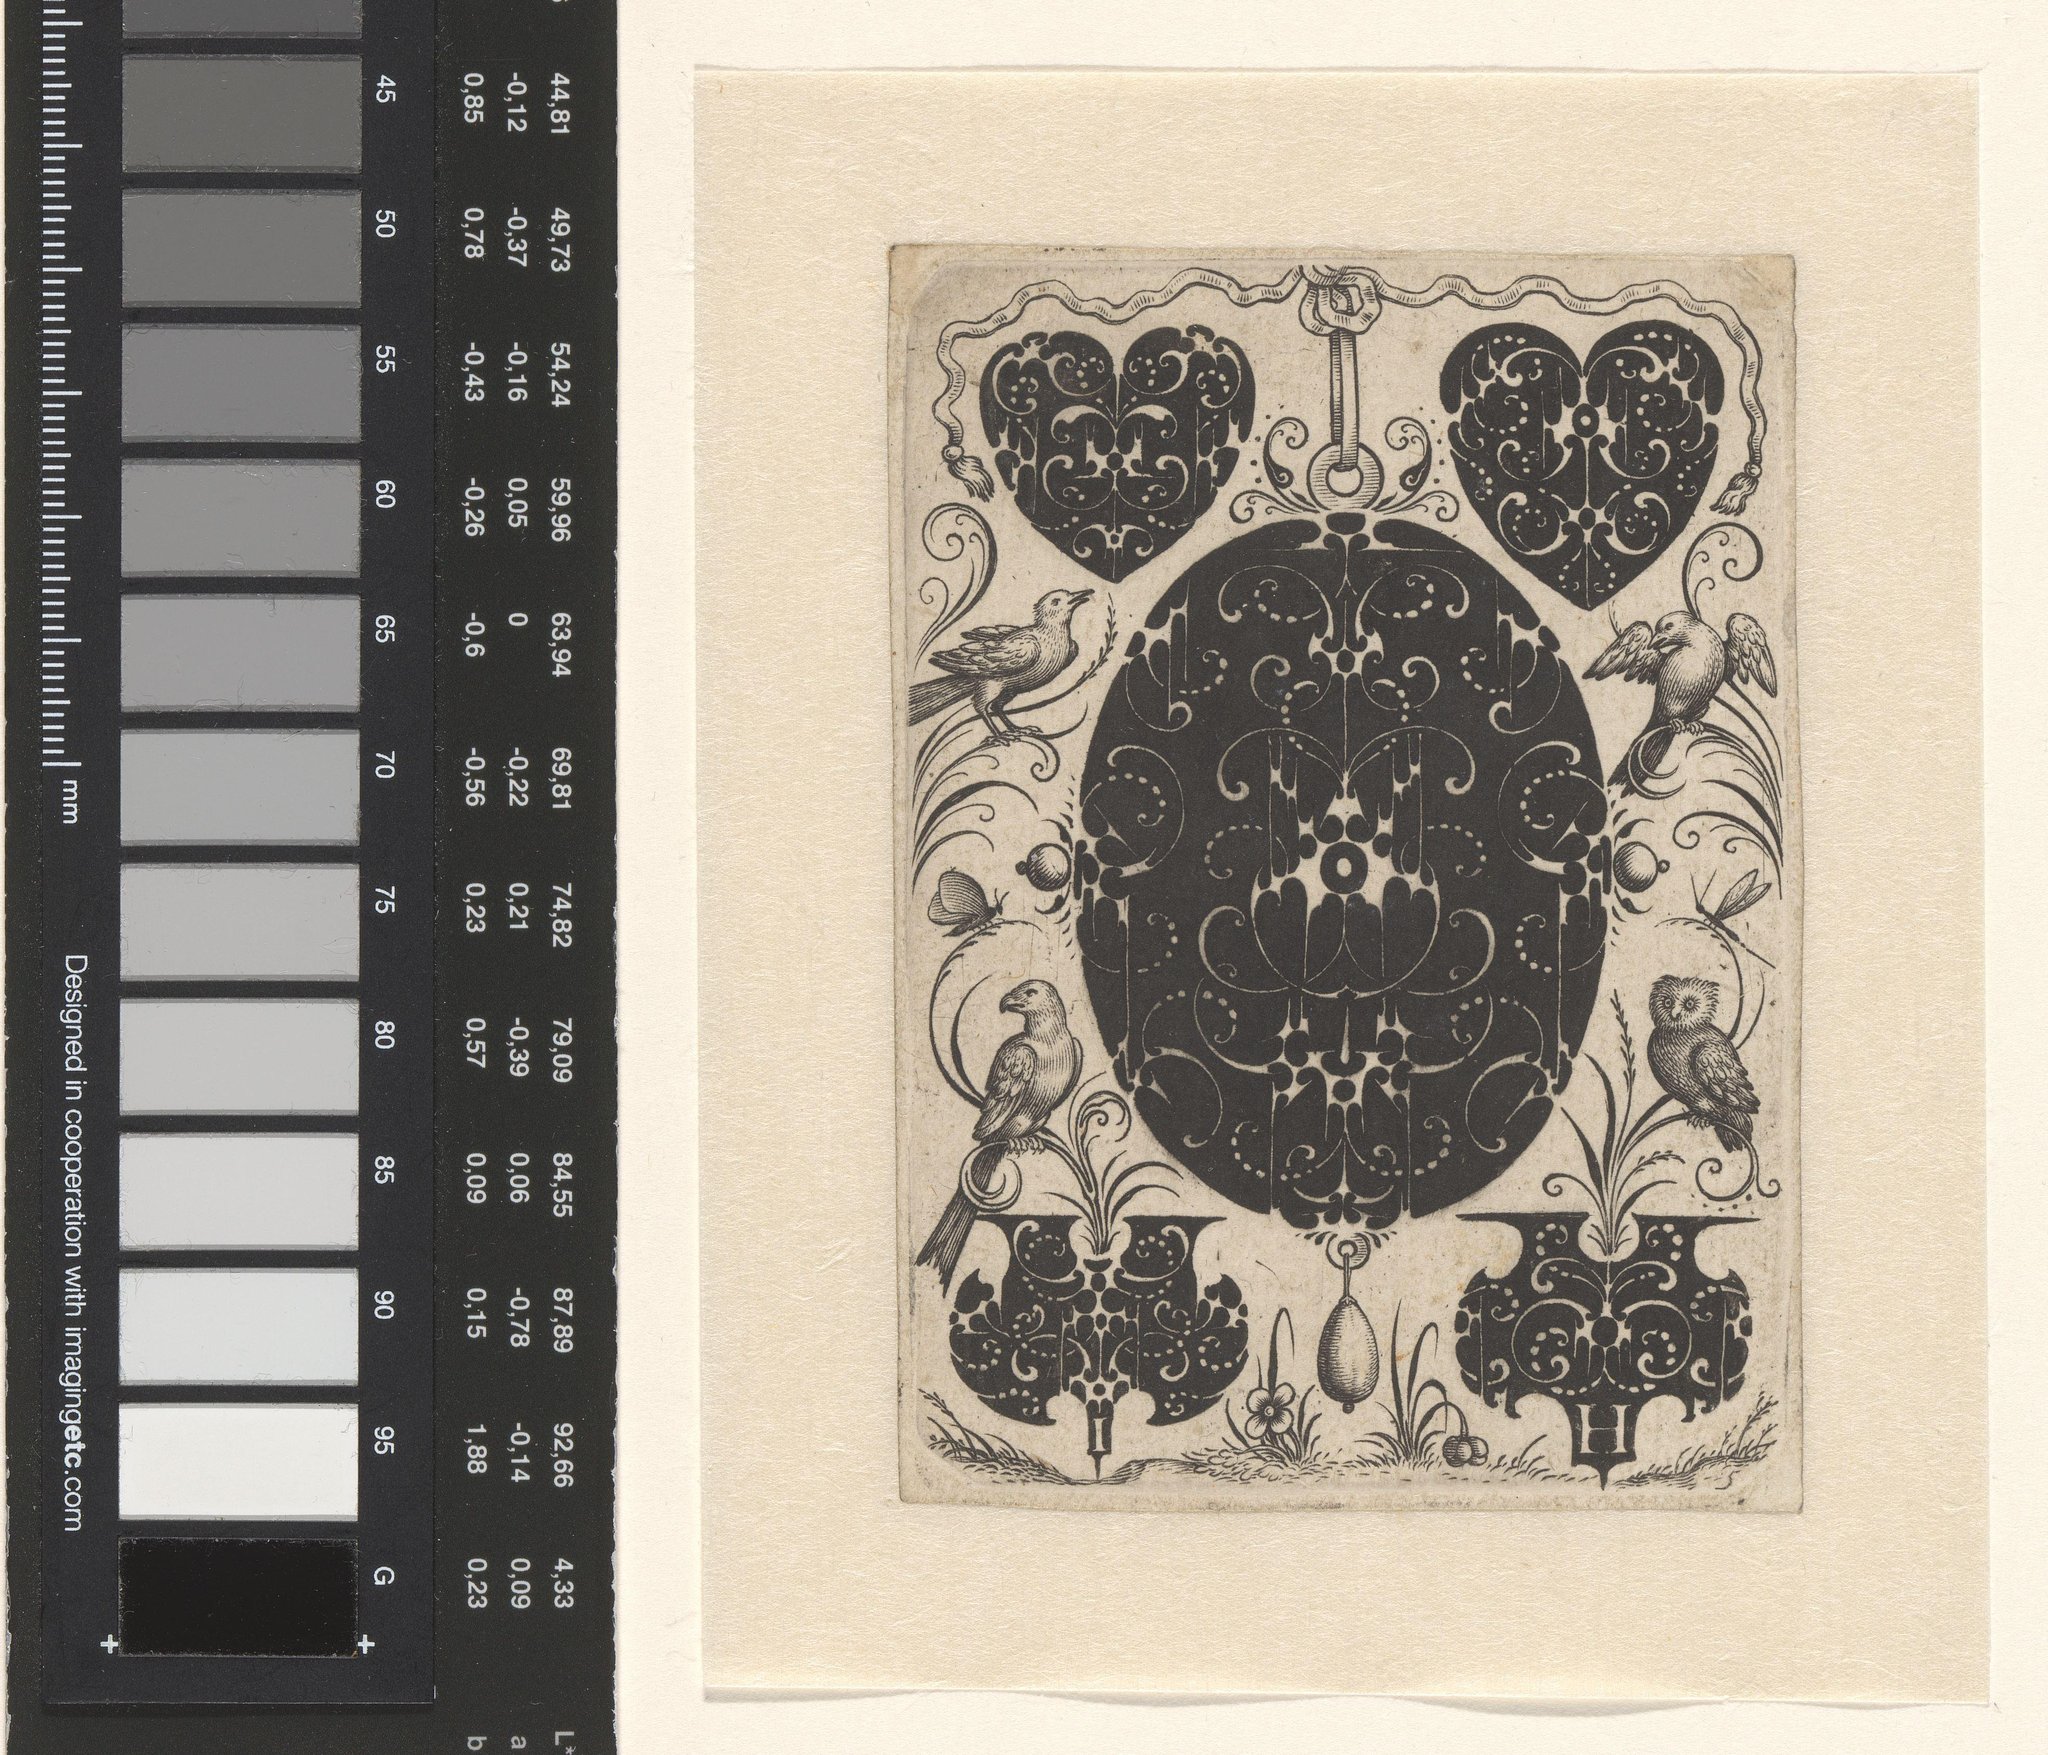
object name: ornament print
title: Zwartwerk ornament met medaillon omgeven door vogels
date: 1615-1620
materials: paper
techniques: engraving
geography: paris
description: Zwartwerk ornament met medaillon met vier hoekstukken. De ornamenten zijn omgeven door verschillende vogels. Nummer 5 uit een reeks van zes ornamentprenten voor goudsmeden.